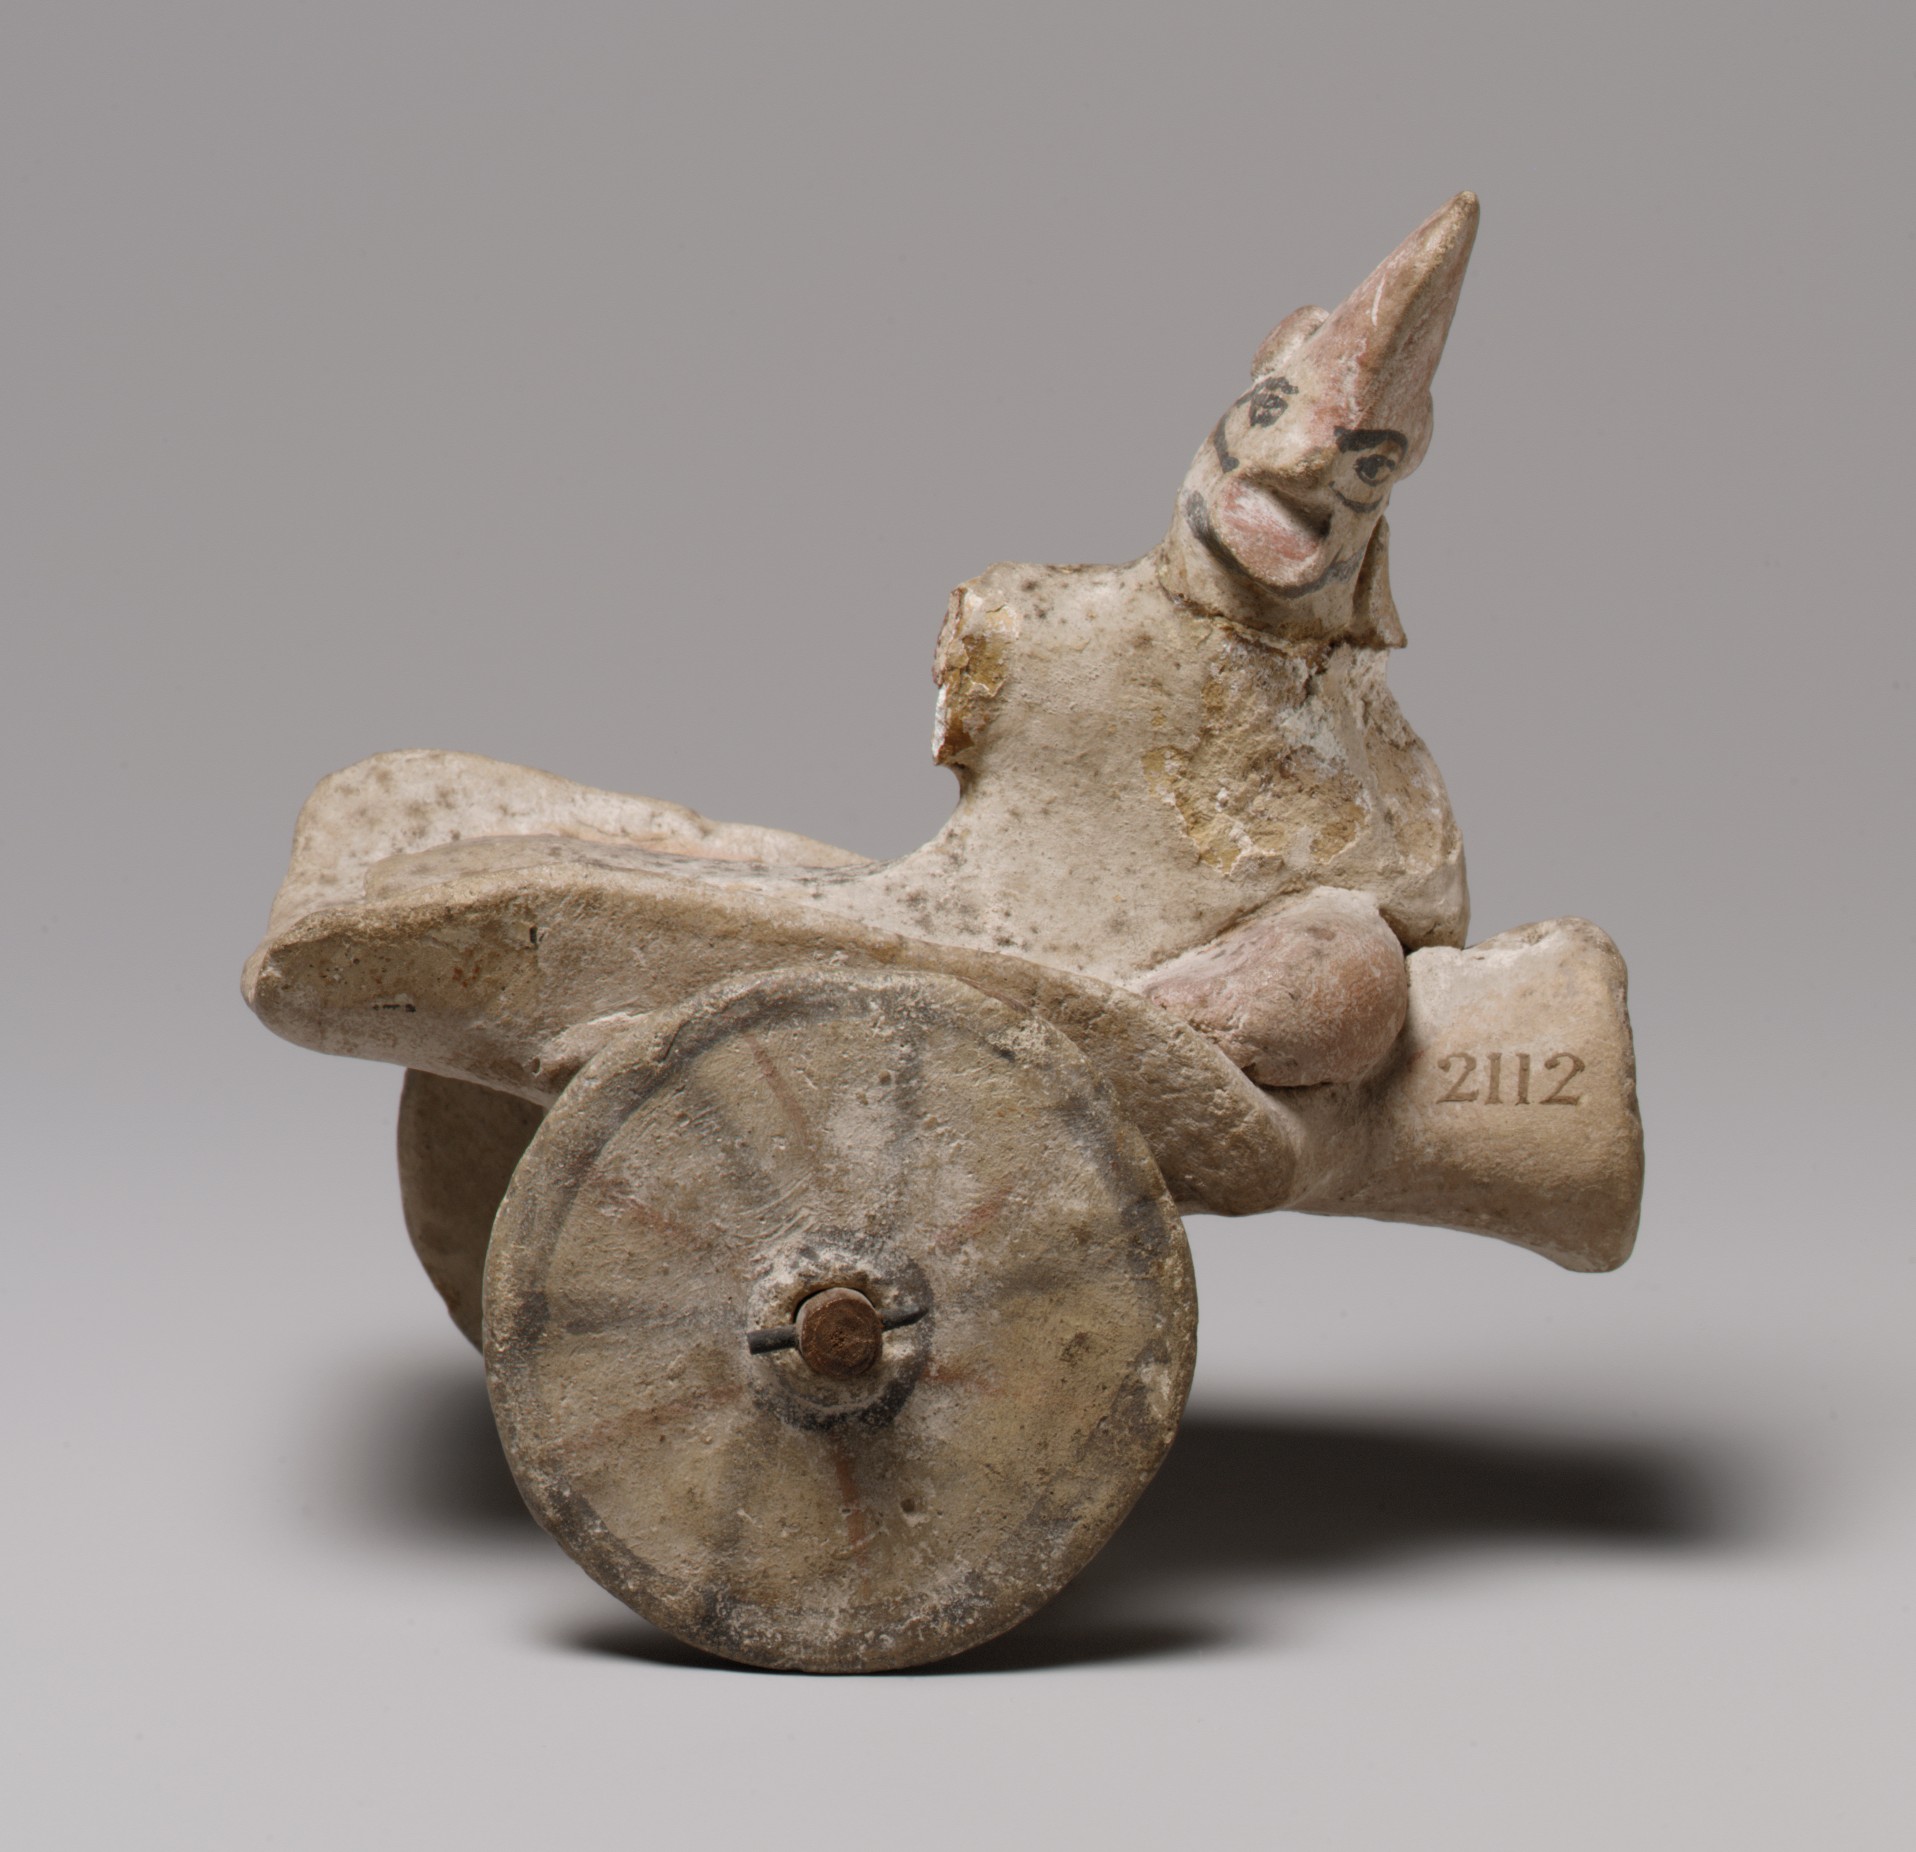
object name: model of a cart with people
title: Model of a cart with a human figure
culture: cypriot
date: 600-480 BCE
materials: terracotta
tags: men,carts